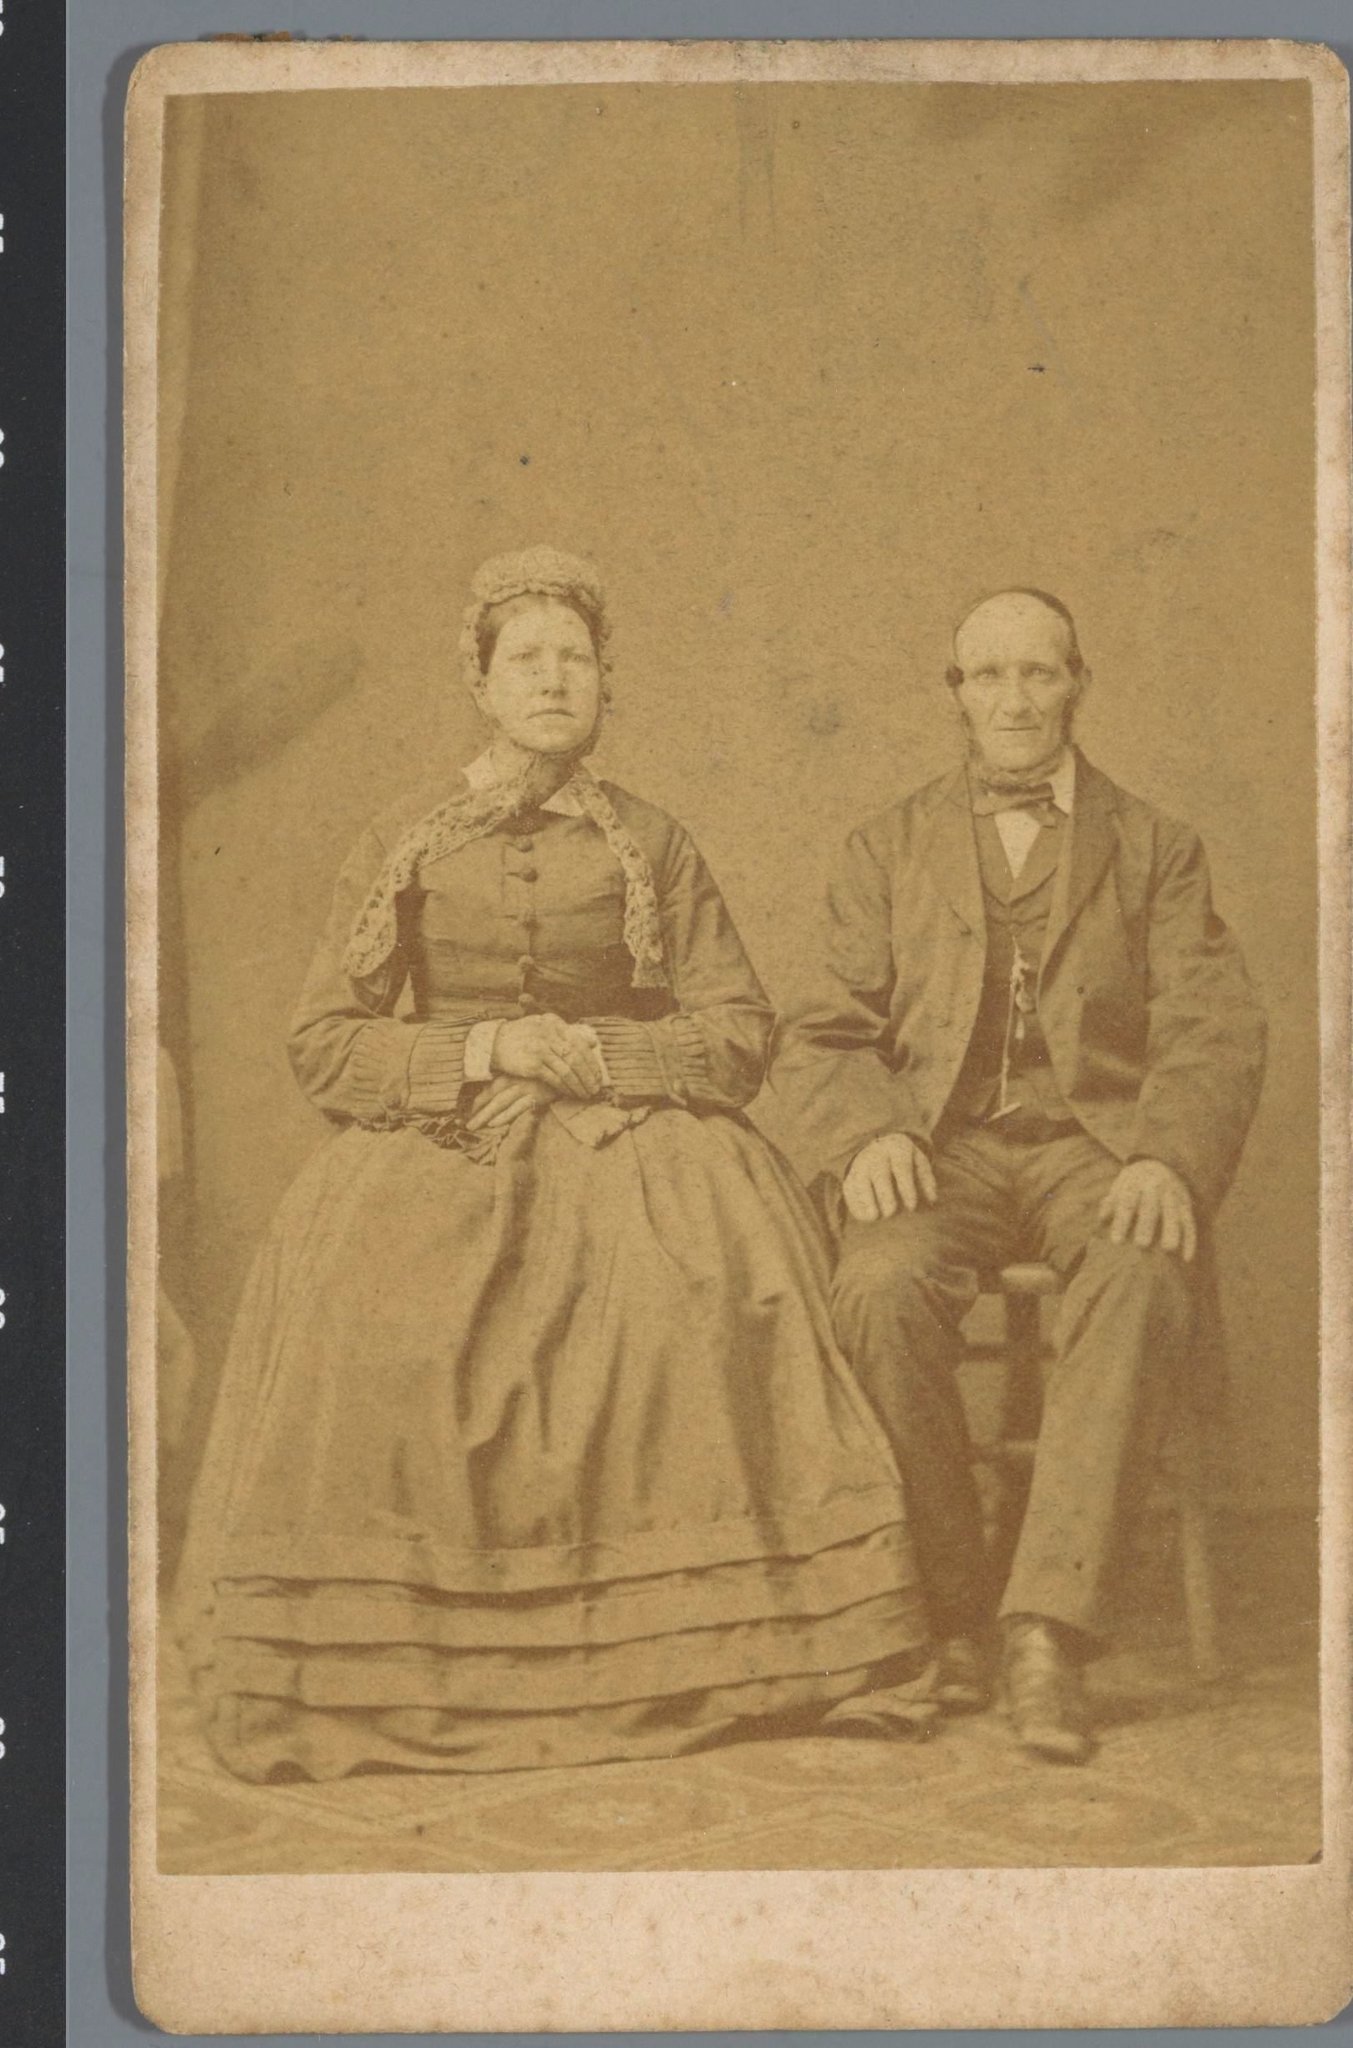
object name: photograph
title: Portret van een onbekende oude man en vrouw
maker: dirk niekerk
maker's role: fotograaf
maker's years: 1824-1881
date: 1875-1879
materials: cardboard, paper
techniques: albumen print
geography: amsterdam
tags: old man, old woman, anonymous historical person portrayed, amsterdam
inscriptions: inscription: ‘Nationale/ 1875/ Tentoonstelling./ D. Niekerk/ Photograaf van Z.K.H. Prins Hendrik/ der Nederlanden,/ Kadijksplein U. 9/ Amsterdam.’